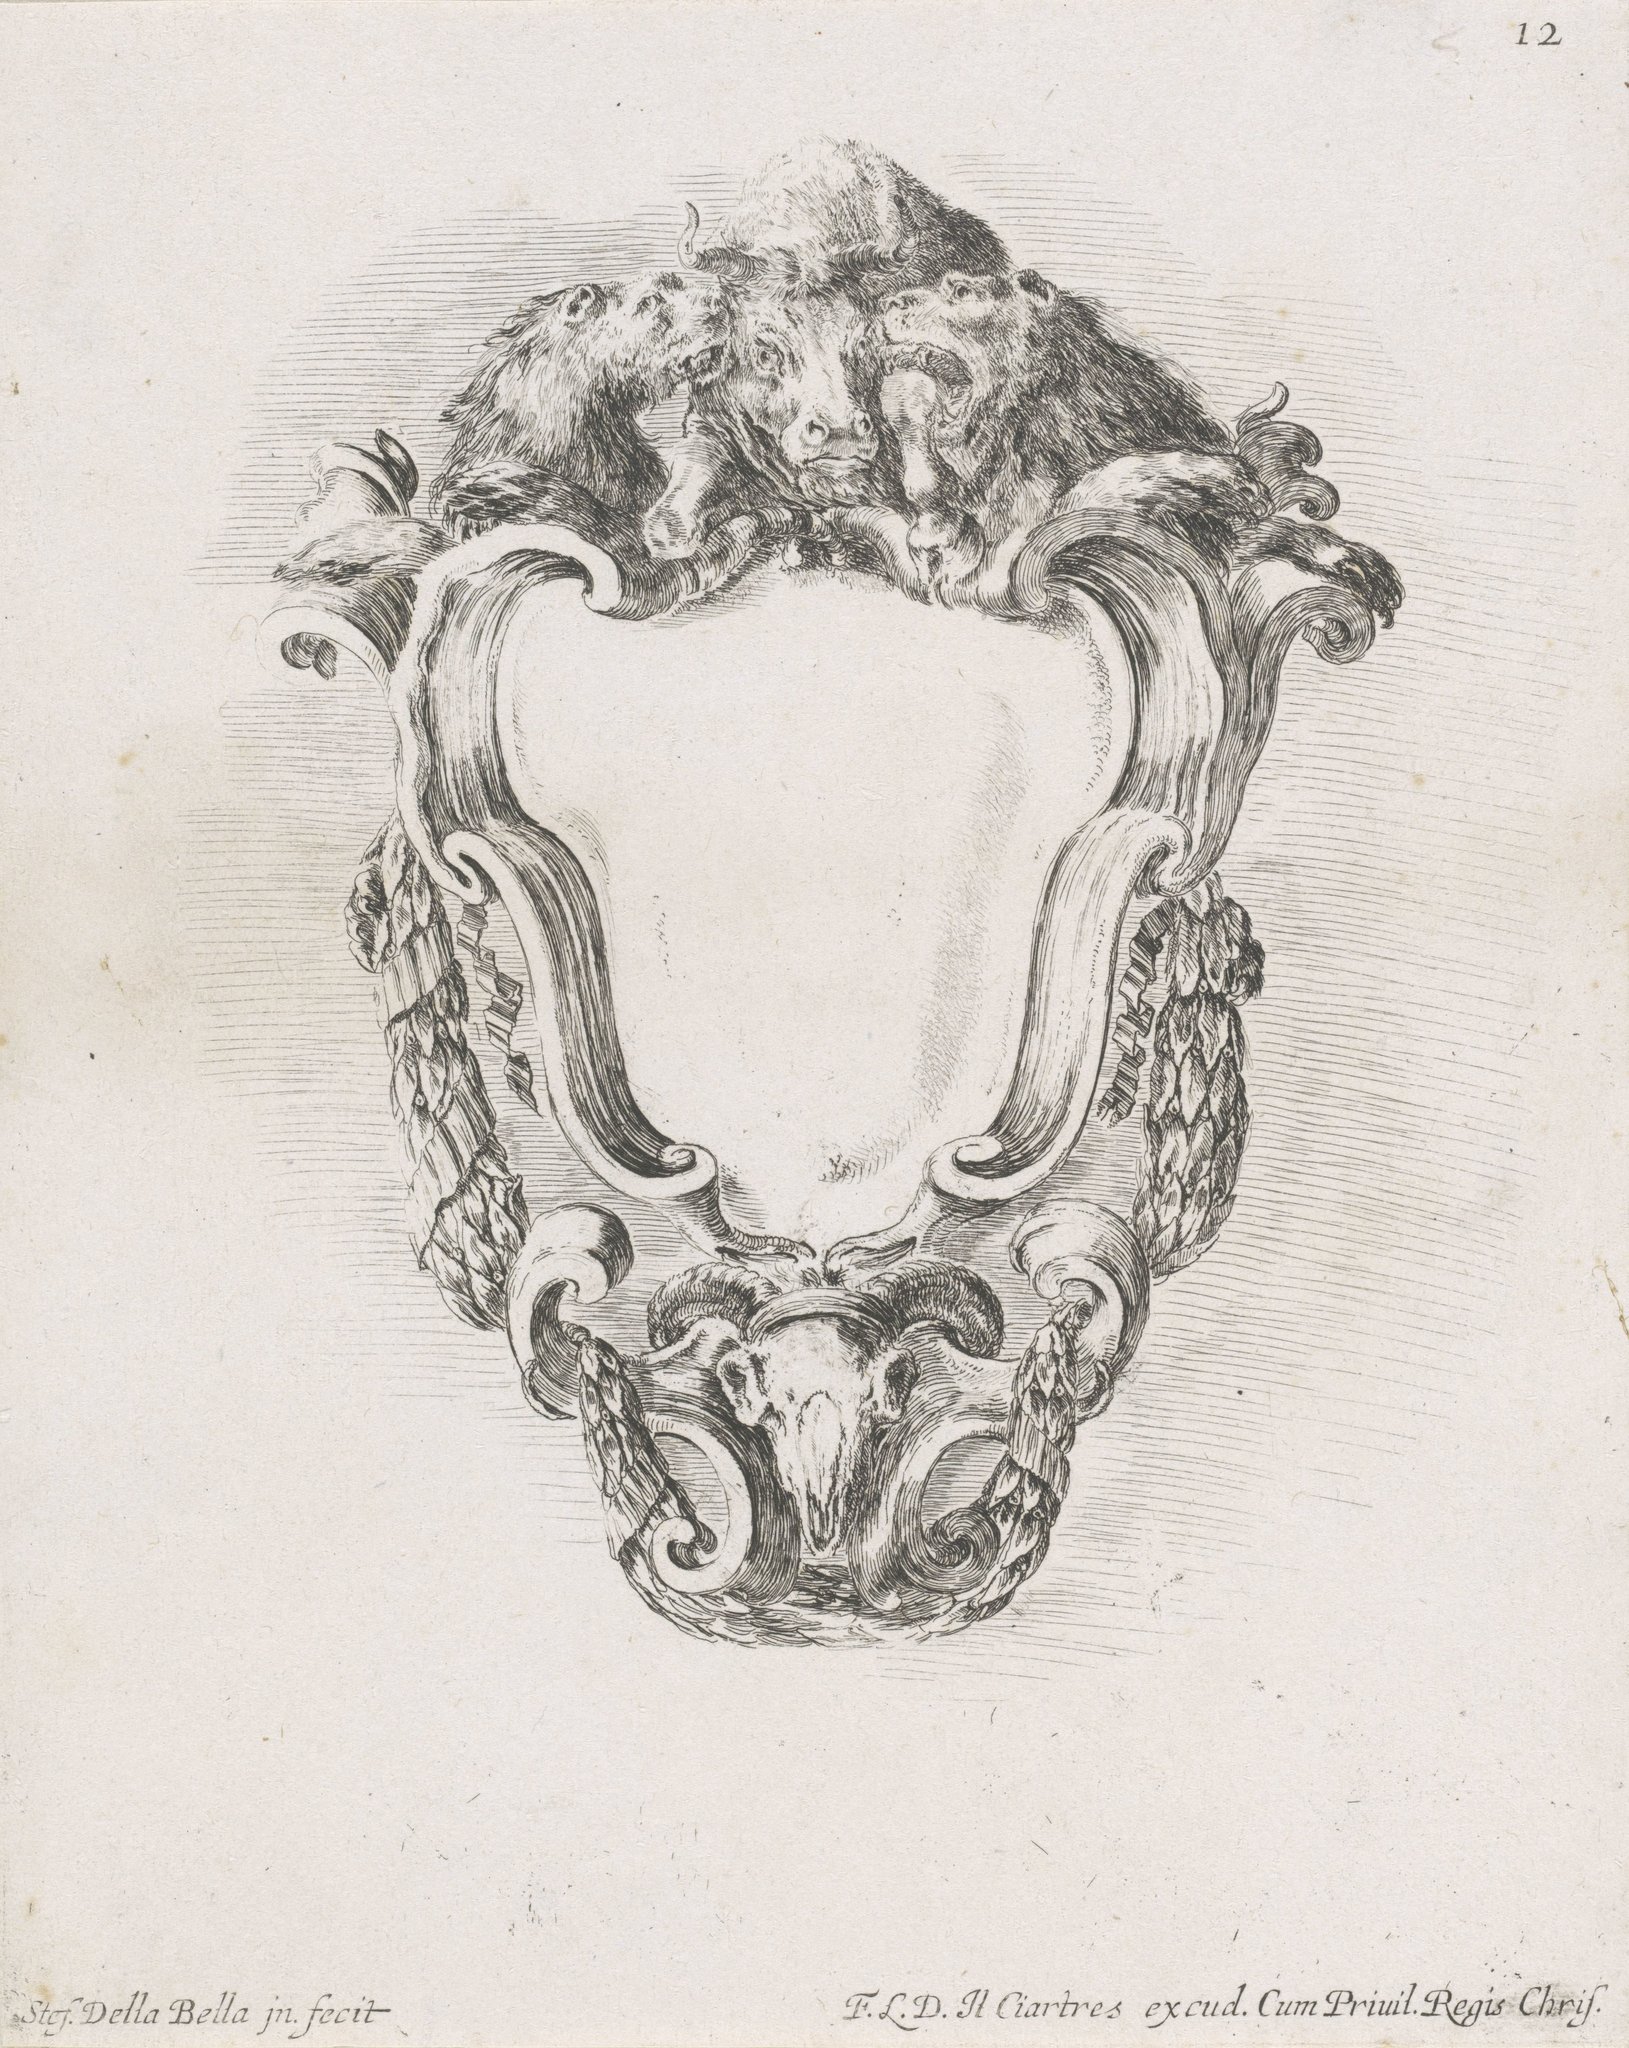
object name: ornament print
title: Cartouche met twee leeuwen, een os en een schedel van een ram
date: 1646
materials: paper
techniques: etching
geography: paris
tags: ram's head ~ ornament, ornament ~ cartouche, ox, beasts of prey, predatory animals: lion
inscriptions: collector's mark: Lugt 240